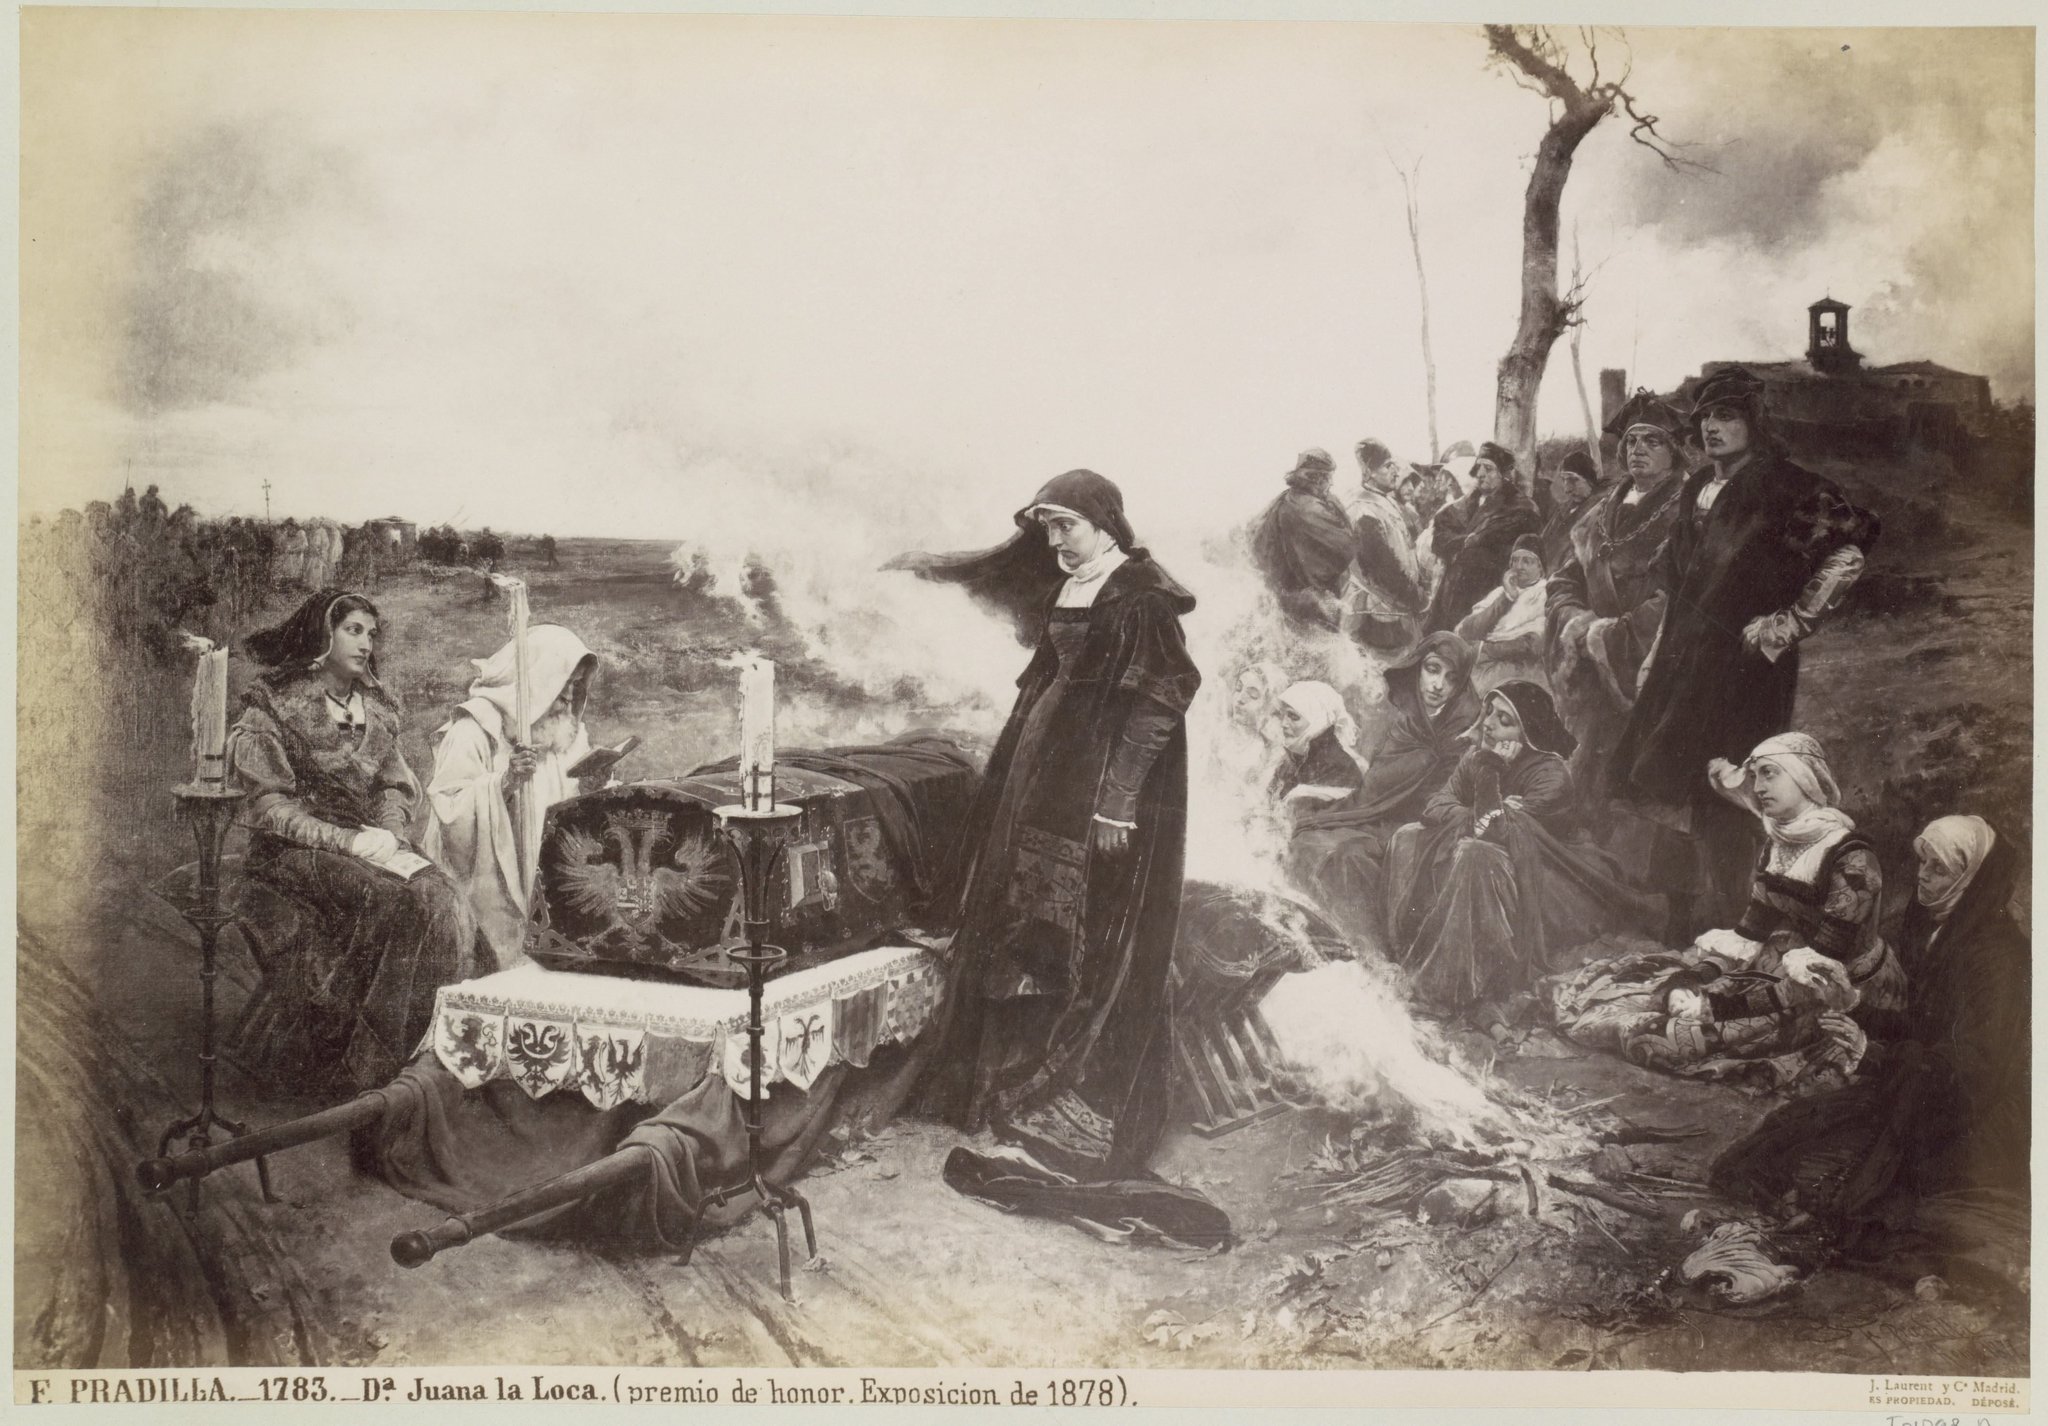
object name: photograph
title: F. PRADILLA.- Da. Juana la Loca. (premio de honor. Exposicion de 1878).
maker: juan laurent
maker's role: publisher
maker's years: 1816-1896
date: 1878-1885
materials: cardboard, paper, photographic support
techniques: albumen print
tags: mourning the dead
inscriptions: negative number: ‘1783’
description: Onderdeel van Reisalbum met foto's van bezienswaardigheden in Spanje en Marokko.